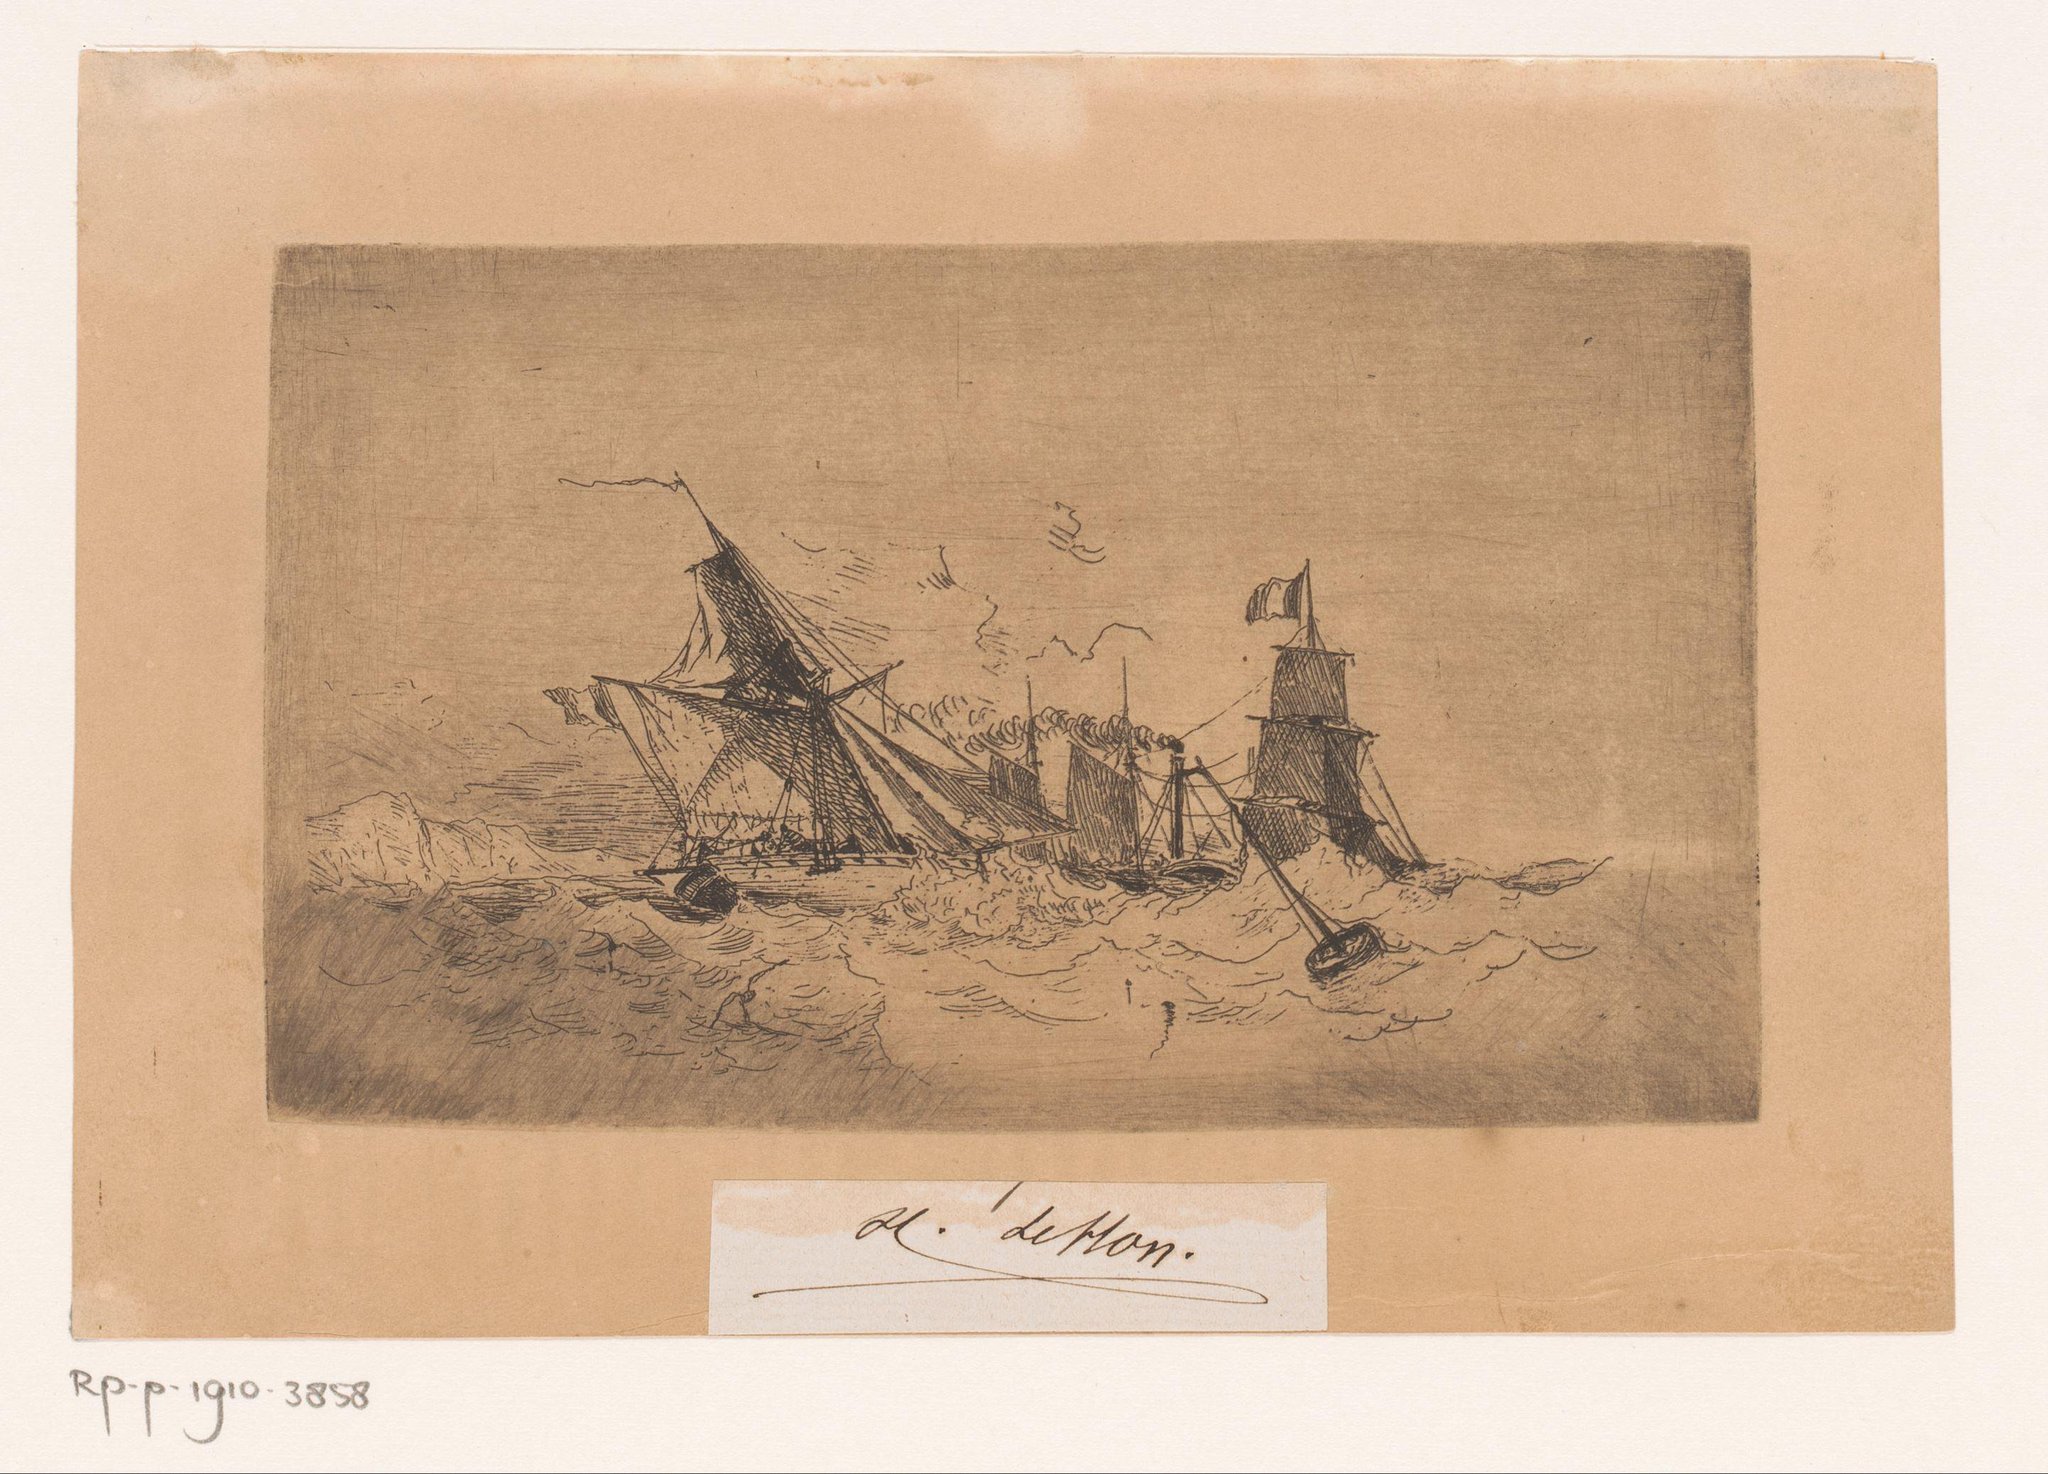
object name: print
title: Stoomschip en zeilschepen op onrustige zee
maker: henri le hon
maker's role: draughtsman, print maker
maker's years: 1809-1872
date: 1819-1872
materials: paper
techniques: etching, intaglio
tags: ships (in general), sea (seascape)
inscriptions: signature